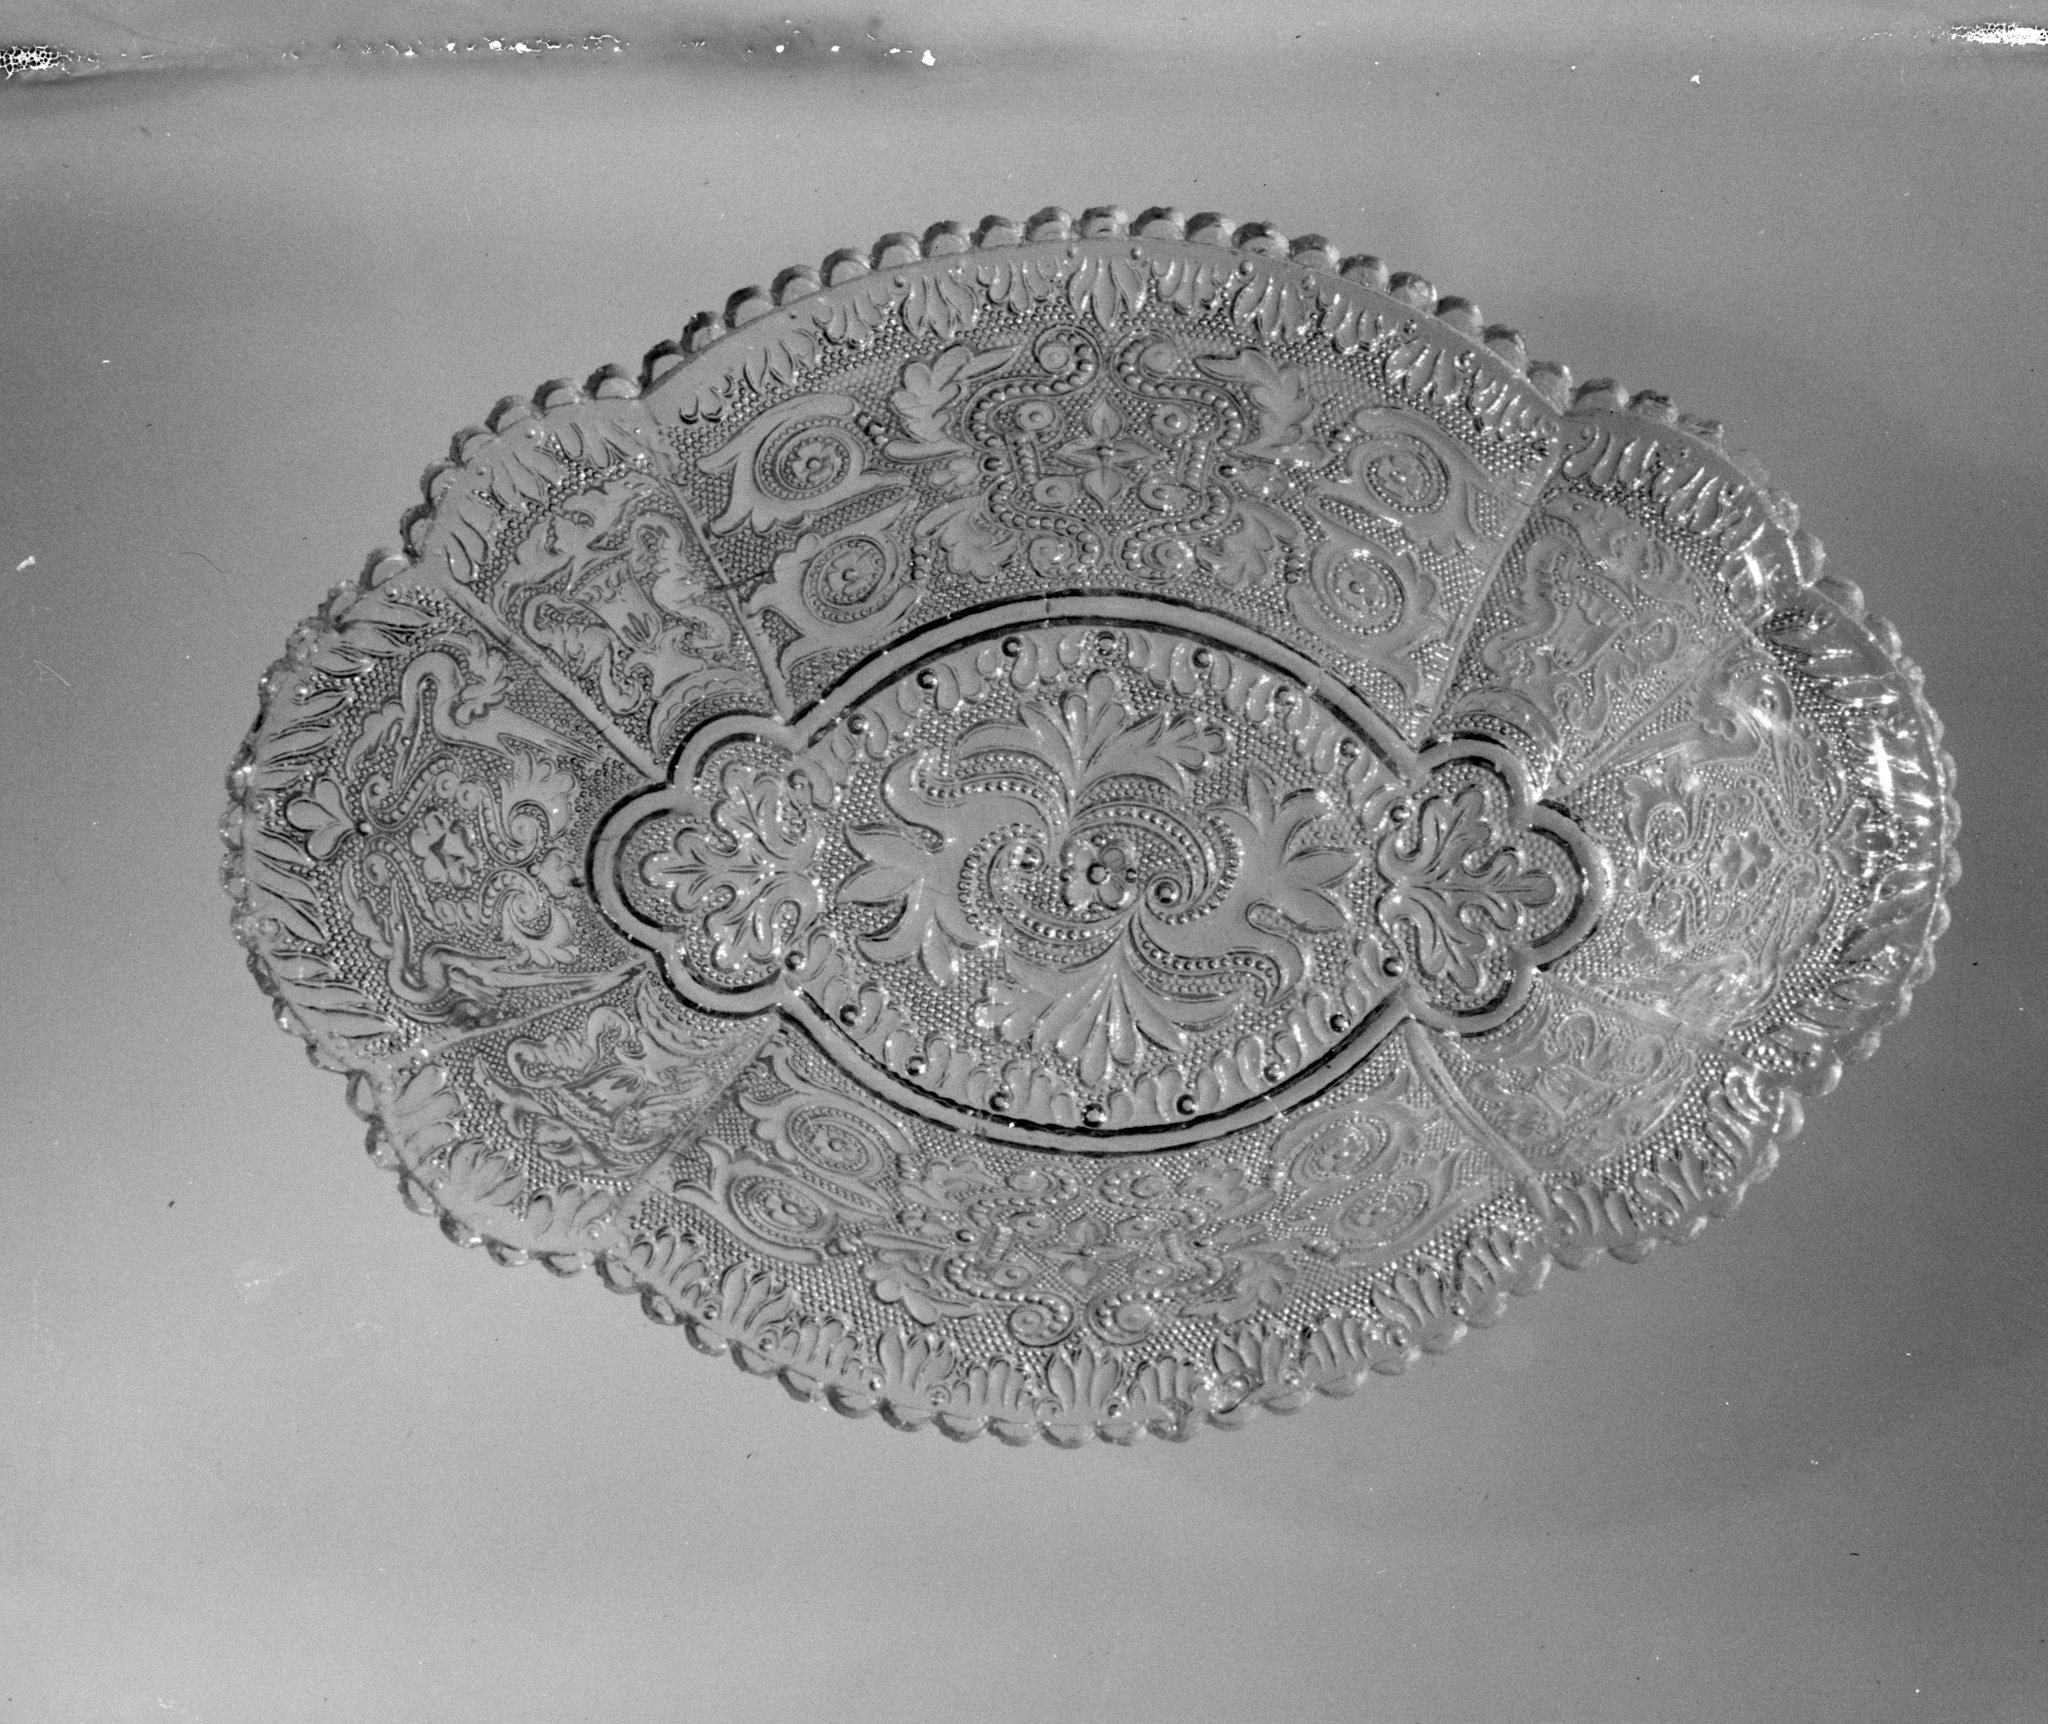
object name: dish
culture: american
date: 1830-1845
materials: glass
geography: united states